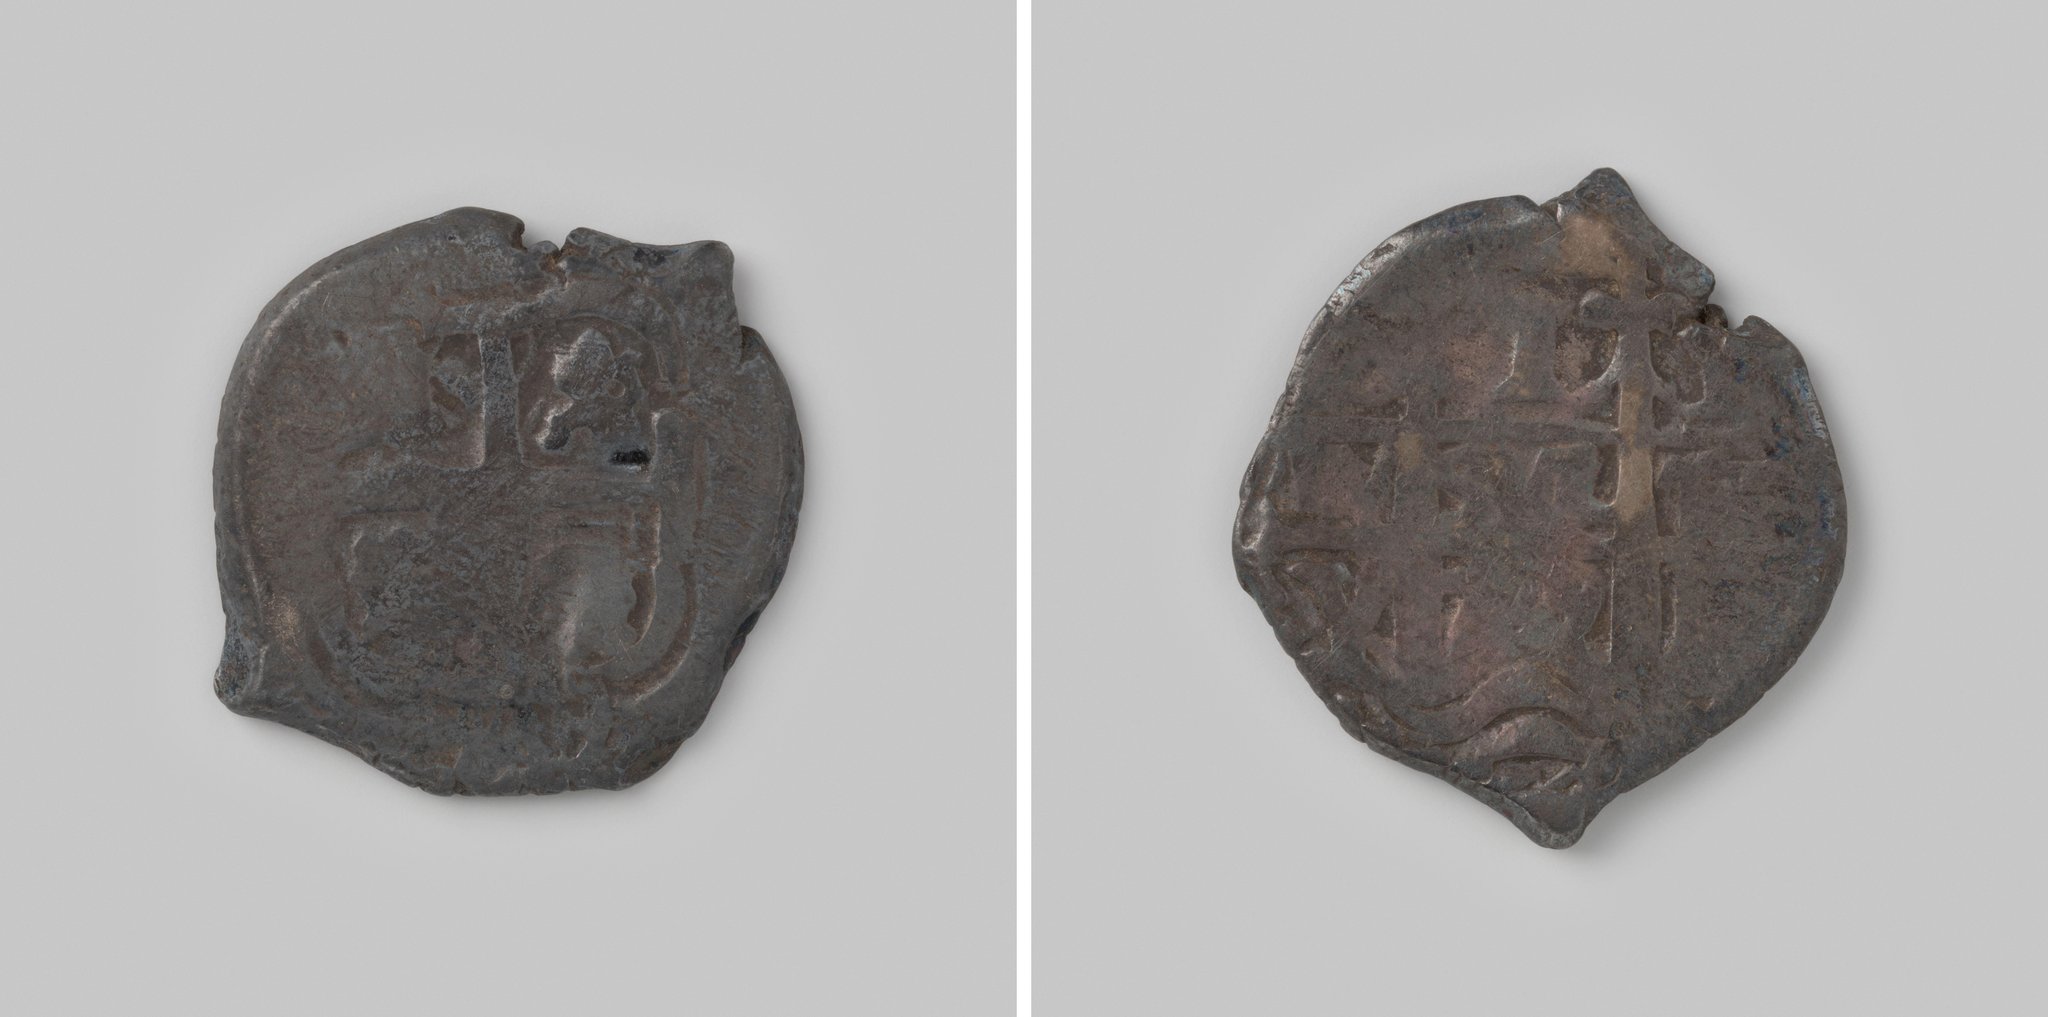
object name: coin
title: Bolivia, Ferdinand VI, reaal,1759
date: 1759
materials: silver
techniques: striking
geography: potosi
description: Zilveren munt uit ruw muntplaatje. Voorzijde: binnen vierpas gelijkbenig herkruist kruis met in de hoeken afwisseld een kasteel en een leeuw. Keerzijde: tussen twee uit zee oprijzende zuilen, waarop versiering, in drie regels waarde-aanduiding: I, opschrift en jaartal: 759. Daartussen tweemaal muntplaats-aanduiding: P [=Potosi].